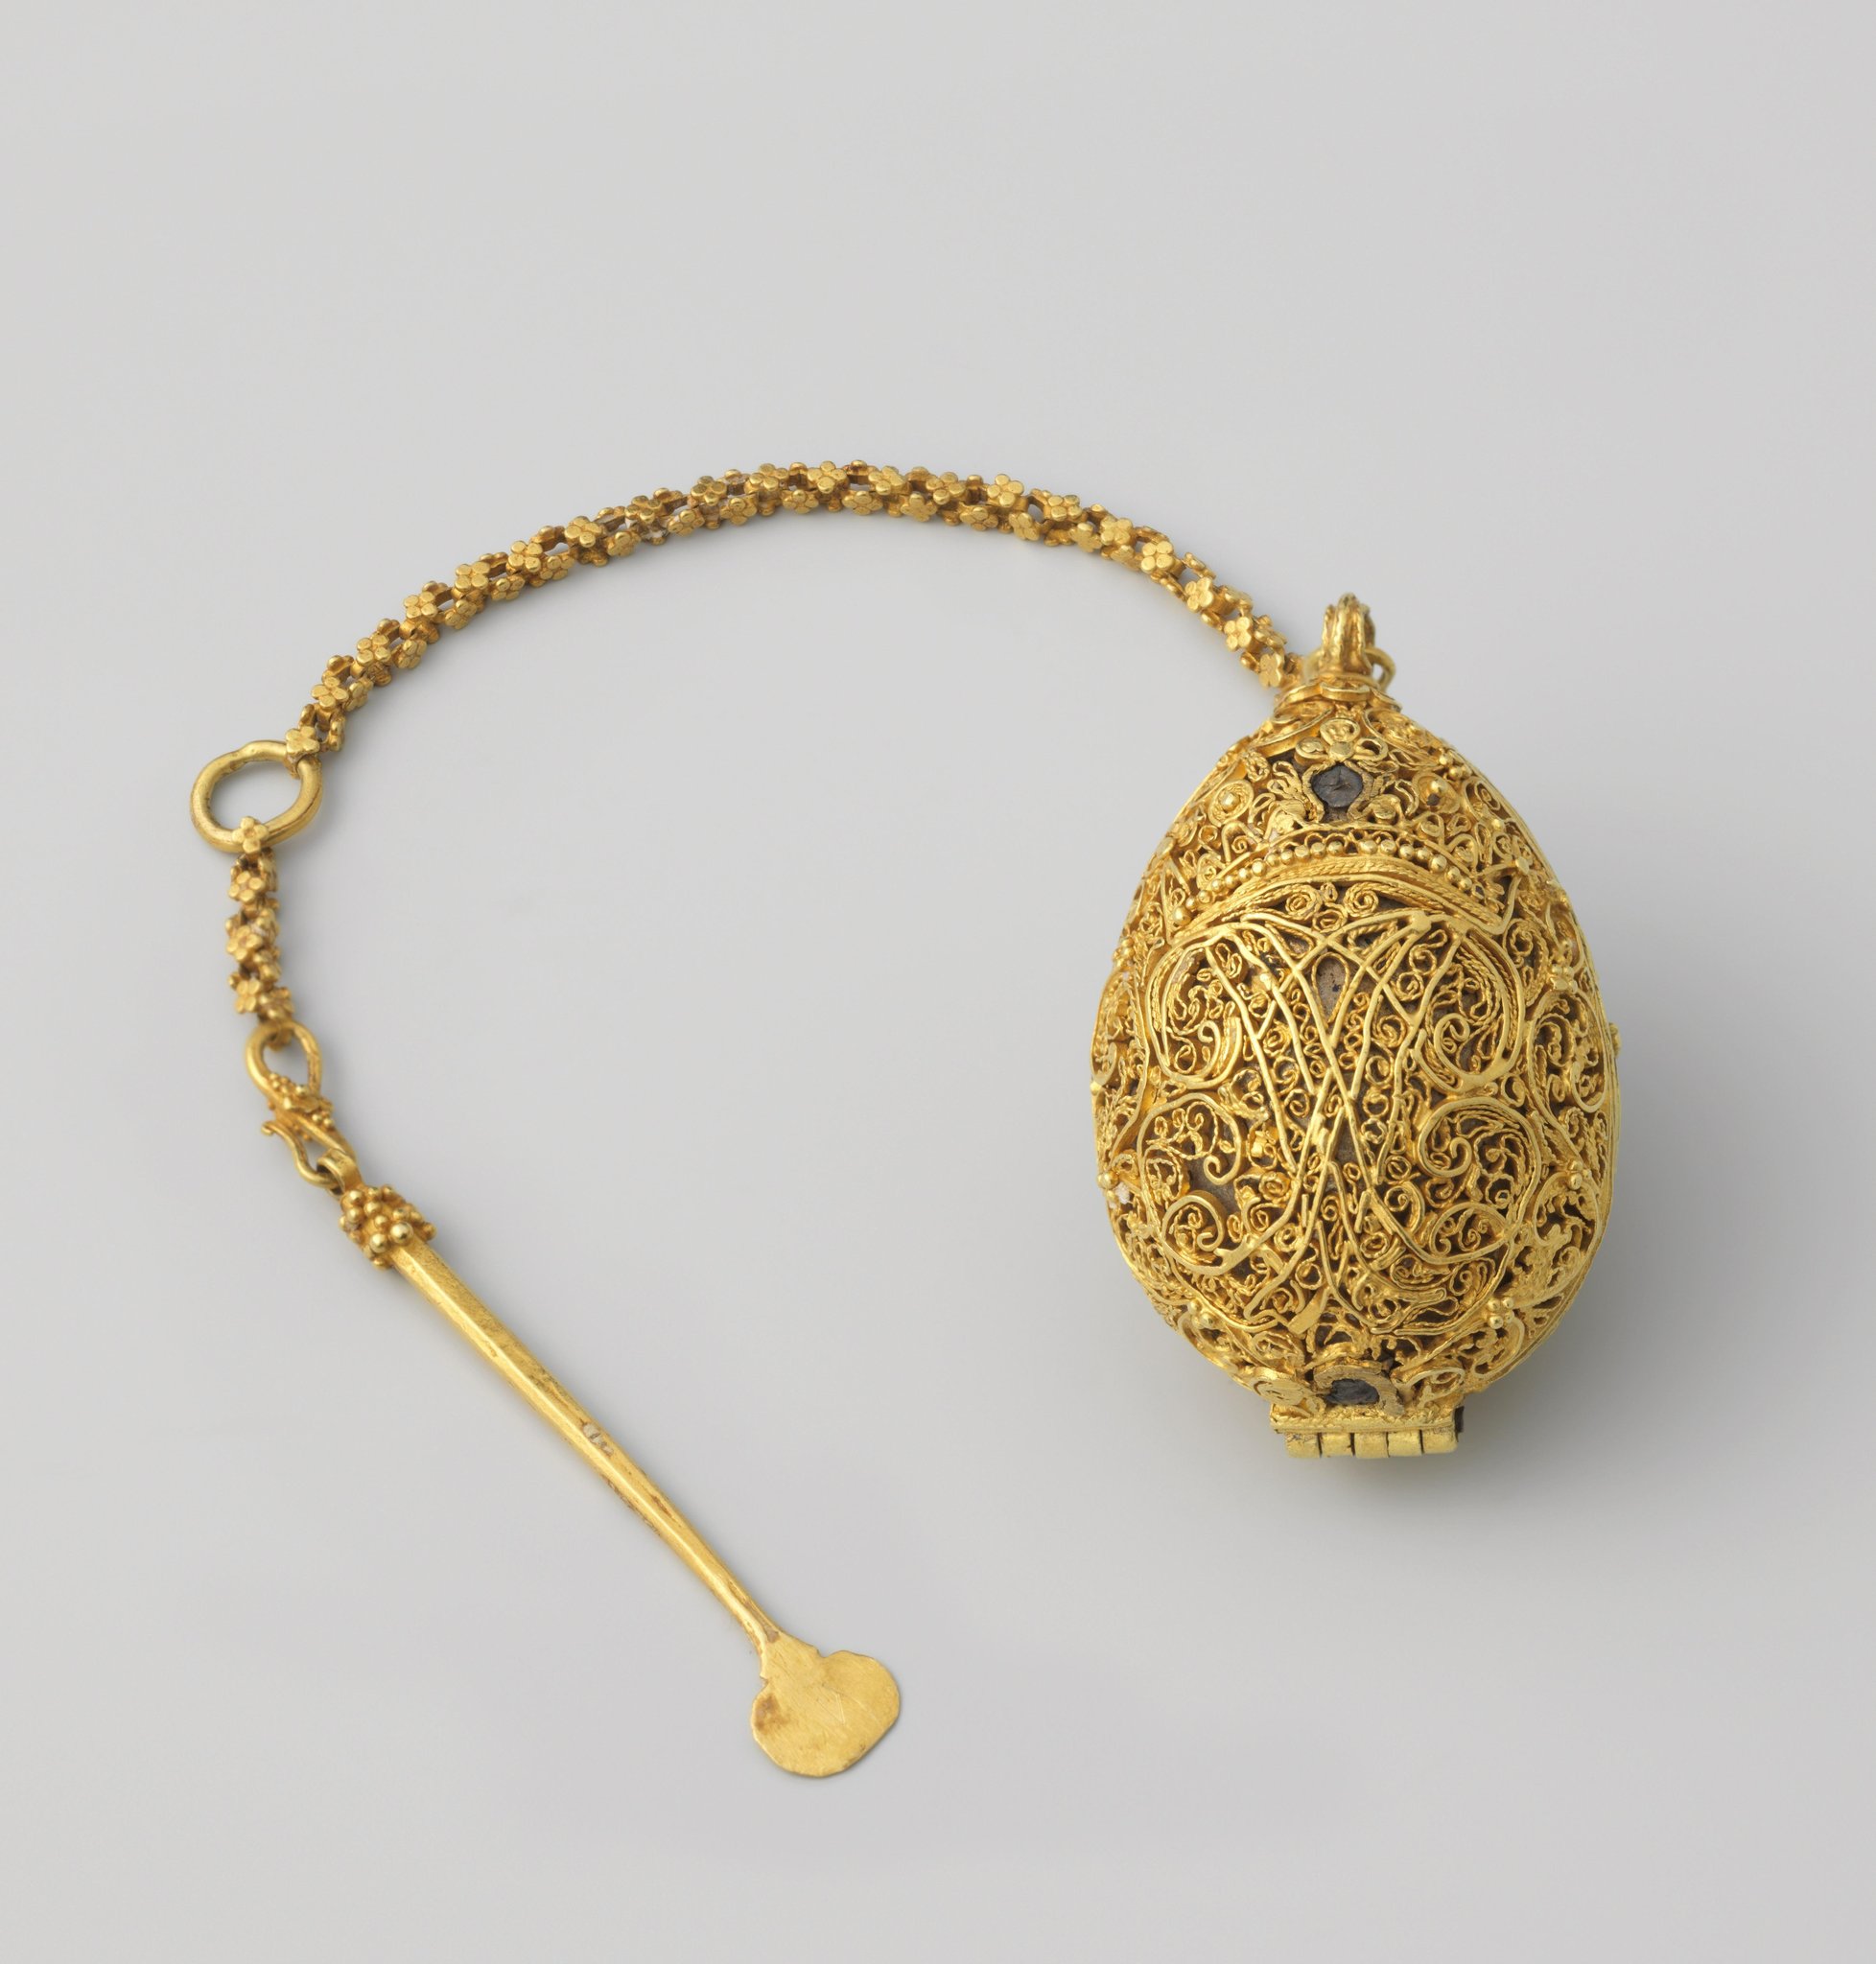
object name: pendant jewelry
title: Hanger (?) in de vorm van een eivormige sirih-bal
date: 1700-1800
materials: gold, silver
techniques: filigree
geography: sri lanka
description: Sirih-bal van goud filigrein met zilveren binnenbakjes. De eivormige bal bestaat uit 2 helften. De bal hangt aan een ketting, waar ook een spateltje aanhangt.